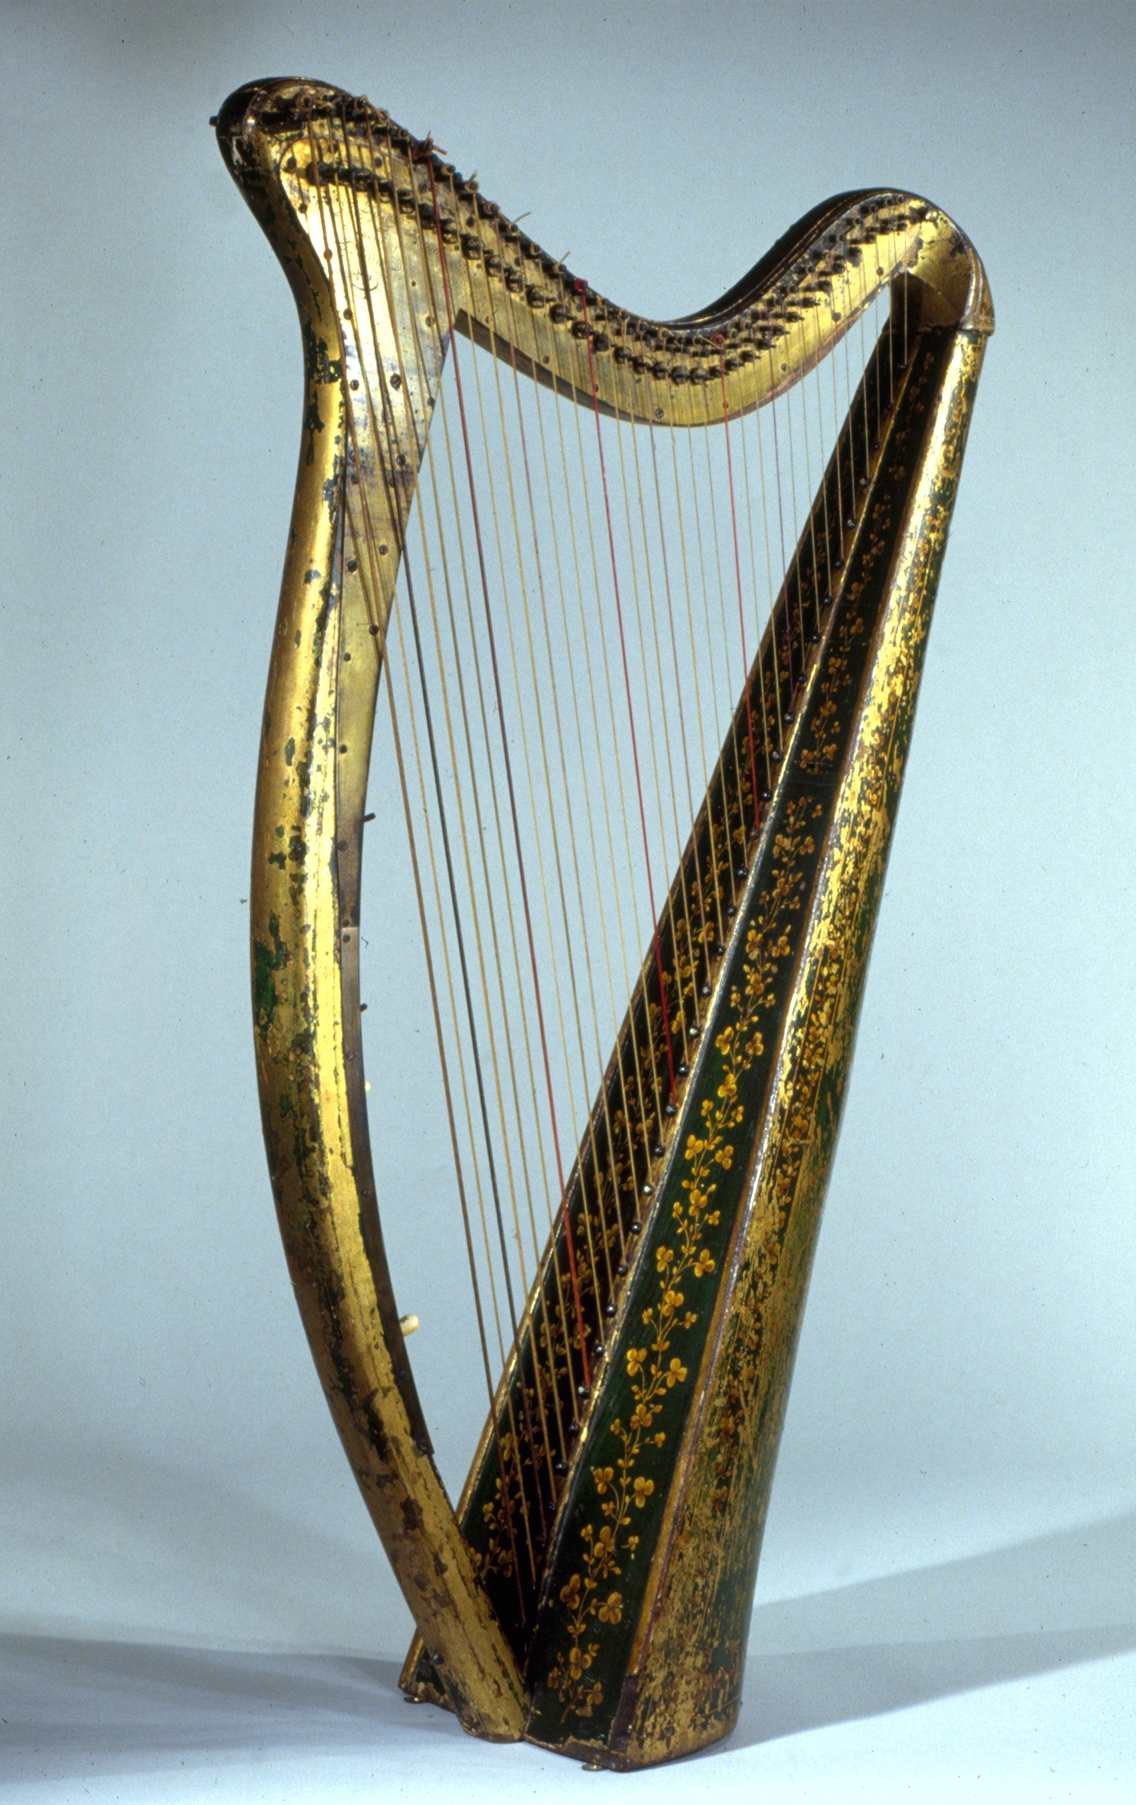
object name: portable harp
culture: irish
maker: john egan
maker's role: maker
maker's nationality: irish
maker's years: 1804-1841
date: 1819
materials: wood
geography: ireland